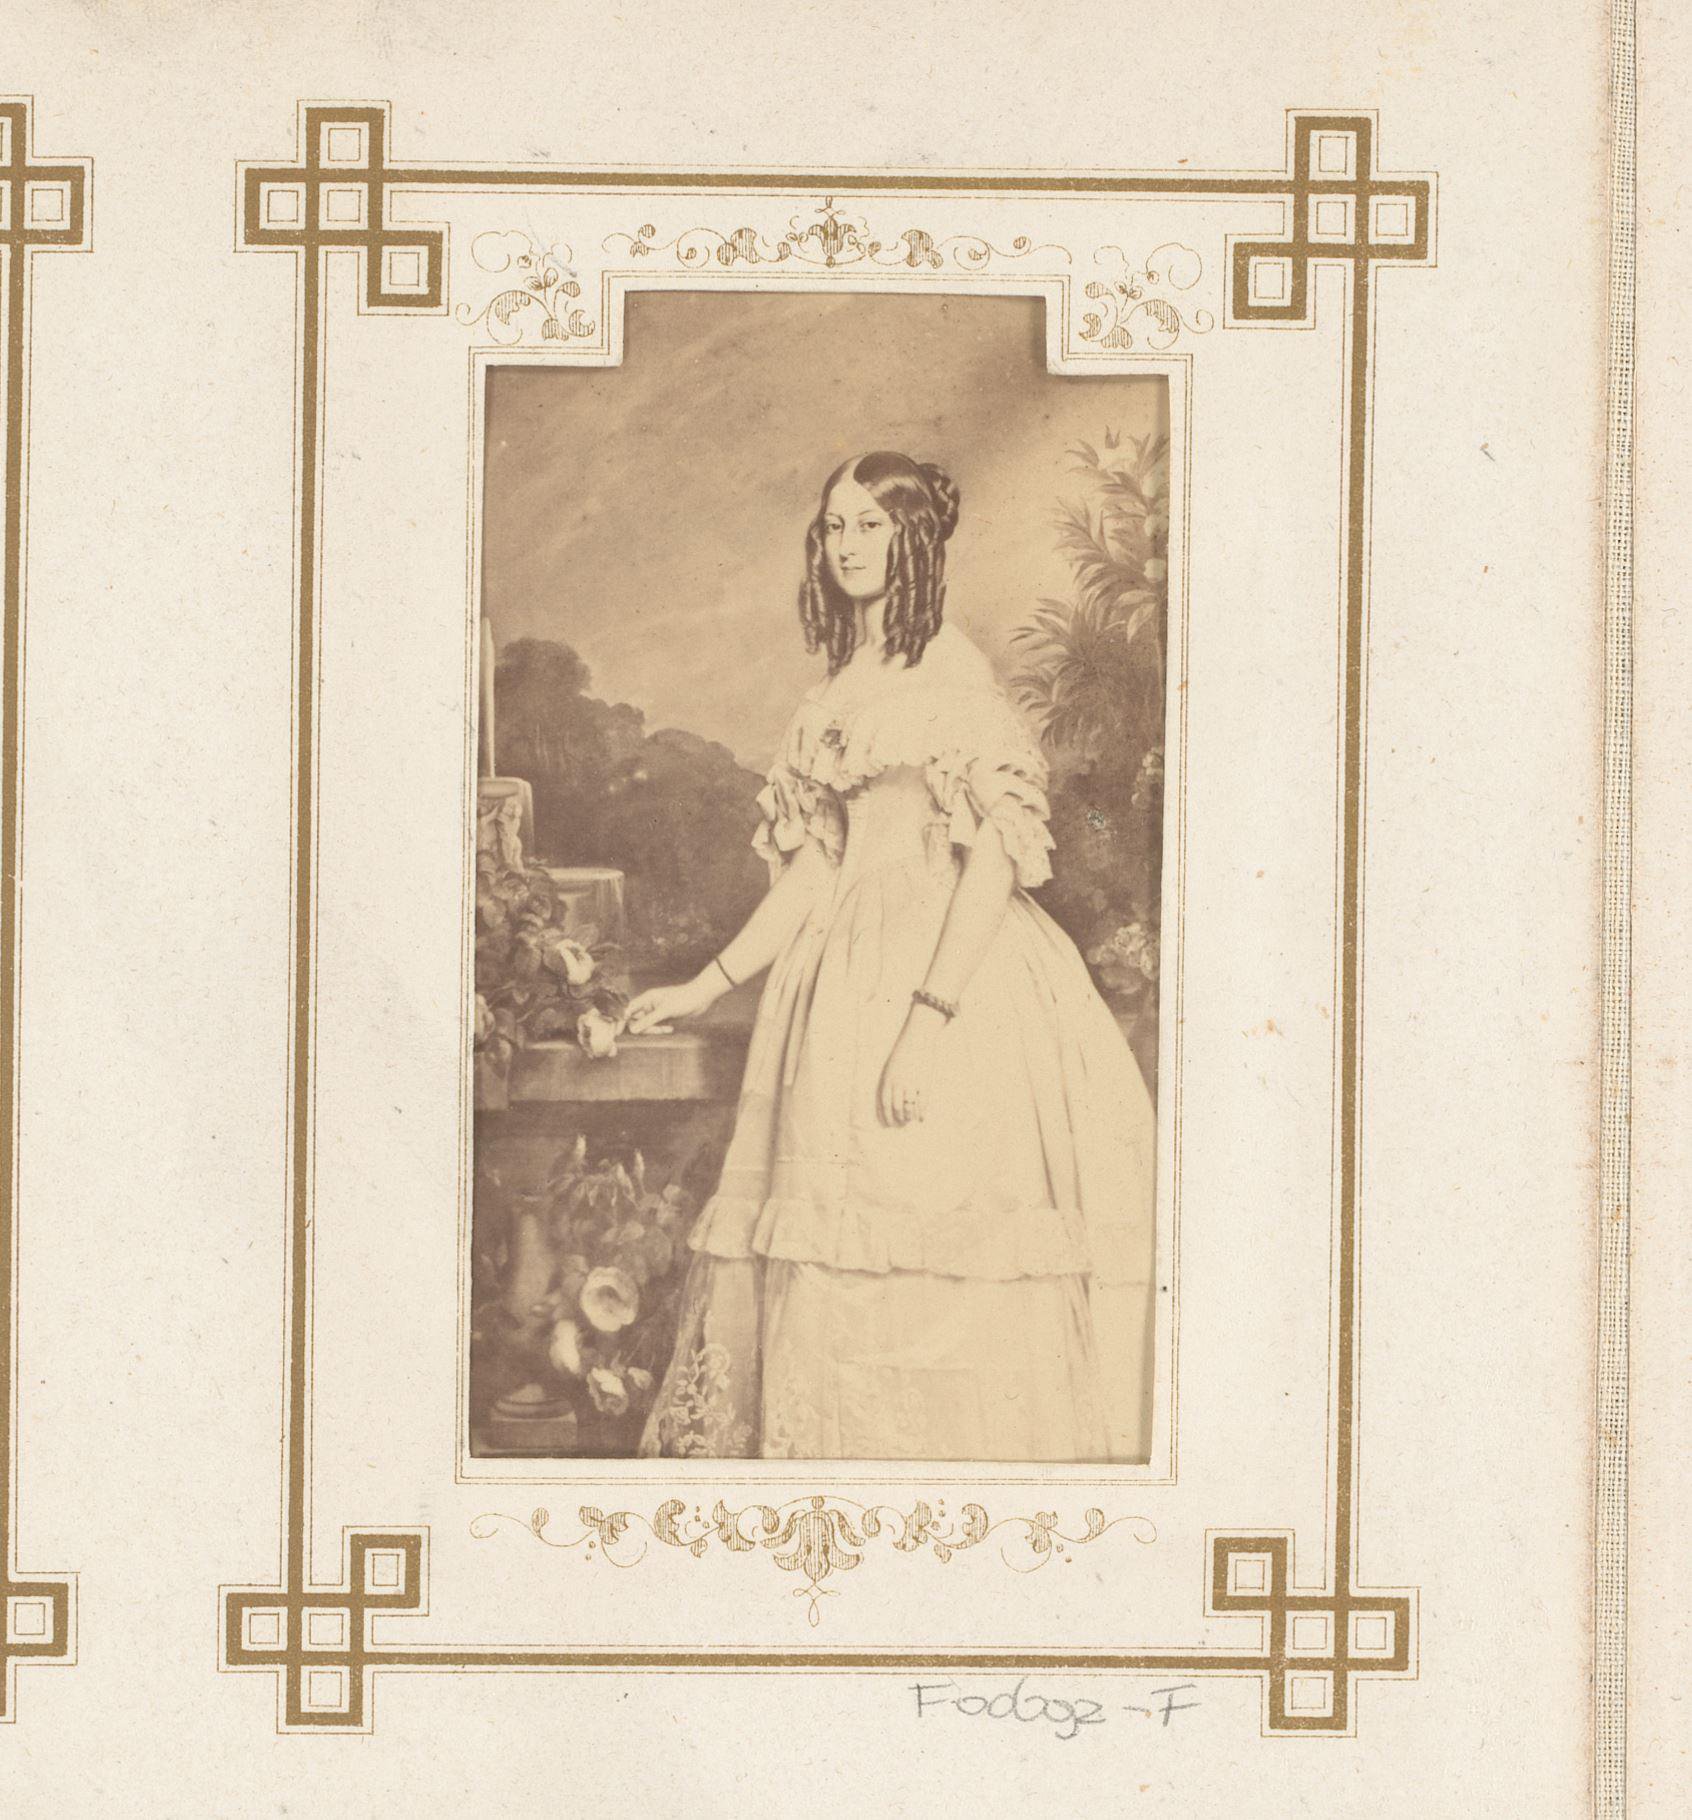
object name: reproduction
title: Fotoreproductie van een geschilderd portret van een jonge vrouw met pijpenkrullen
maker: Anonymous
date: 1855-1890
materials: cardboard, photographic support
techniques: albumen print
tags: adolescent, young woman, maiden